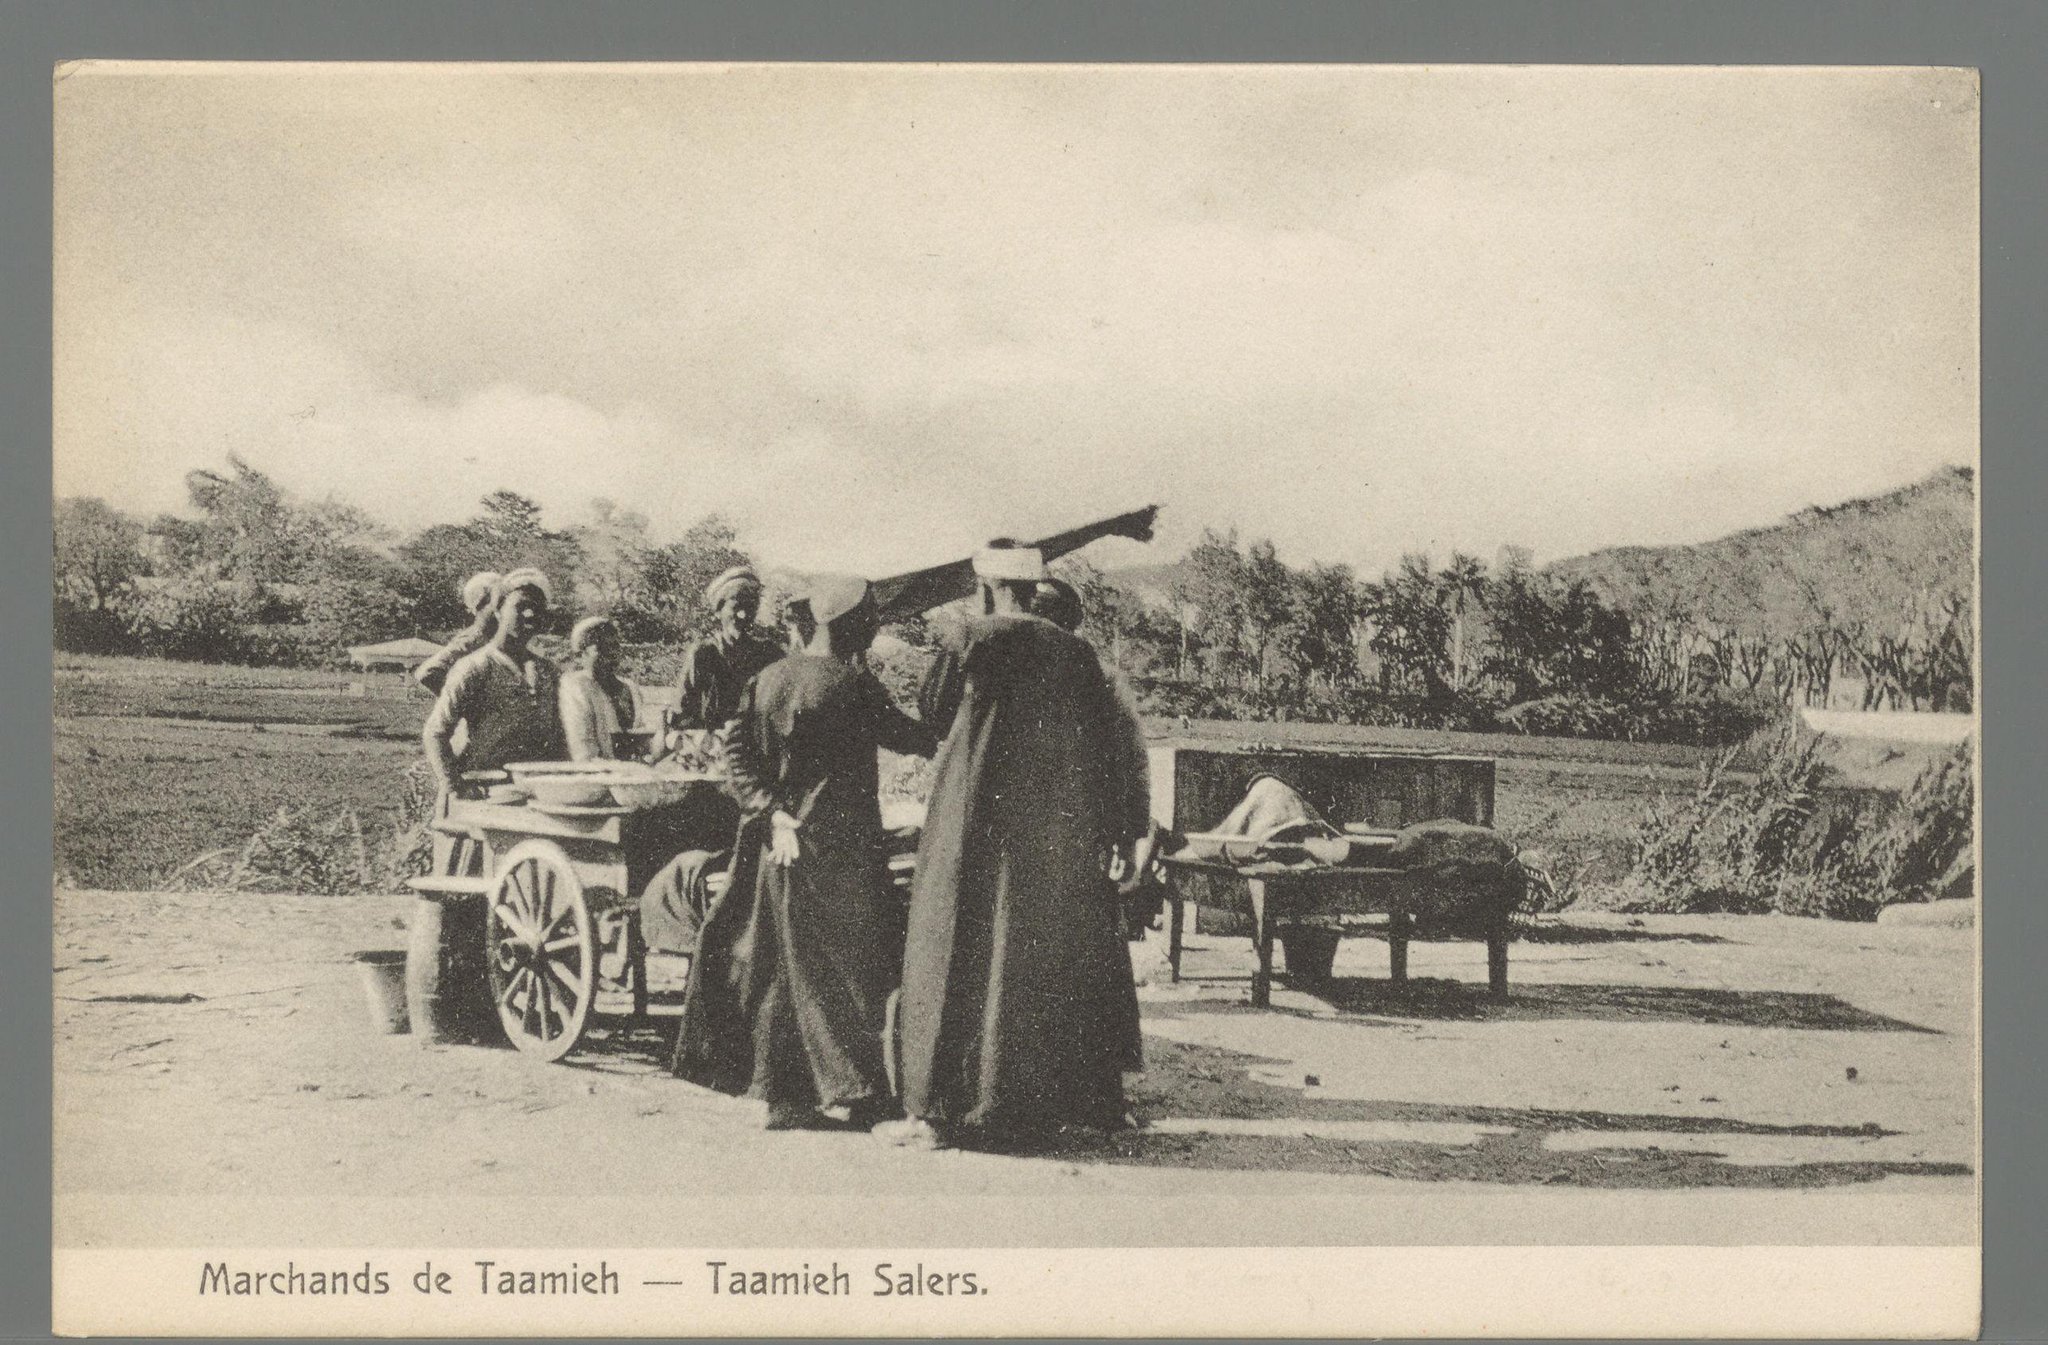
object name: photomechanical print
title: Marchands de Taamieh / Taamieh salers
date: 1907-1930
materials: cardboard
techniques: photograph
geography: egypt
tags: street-trader